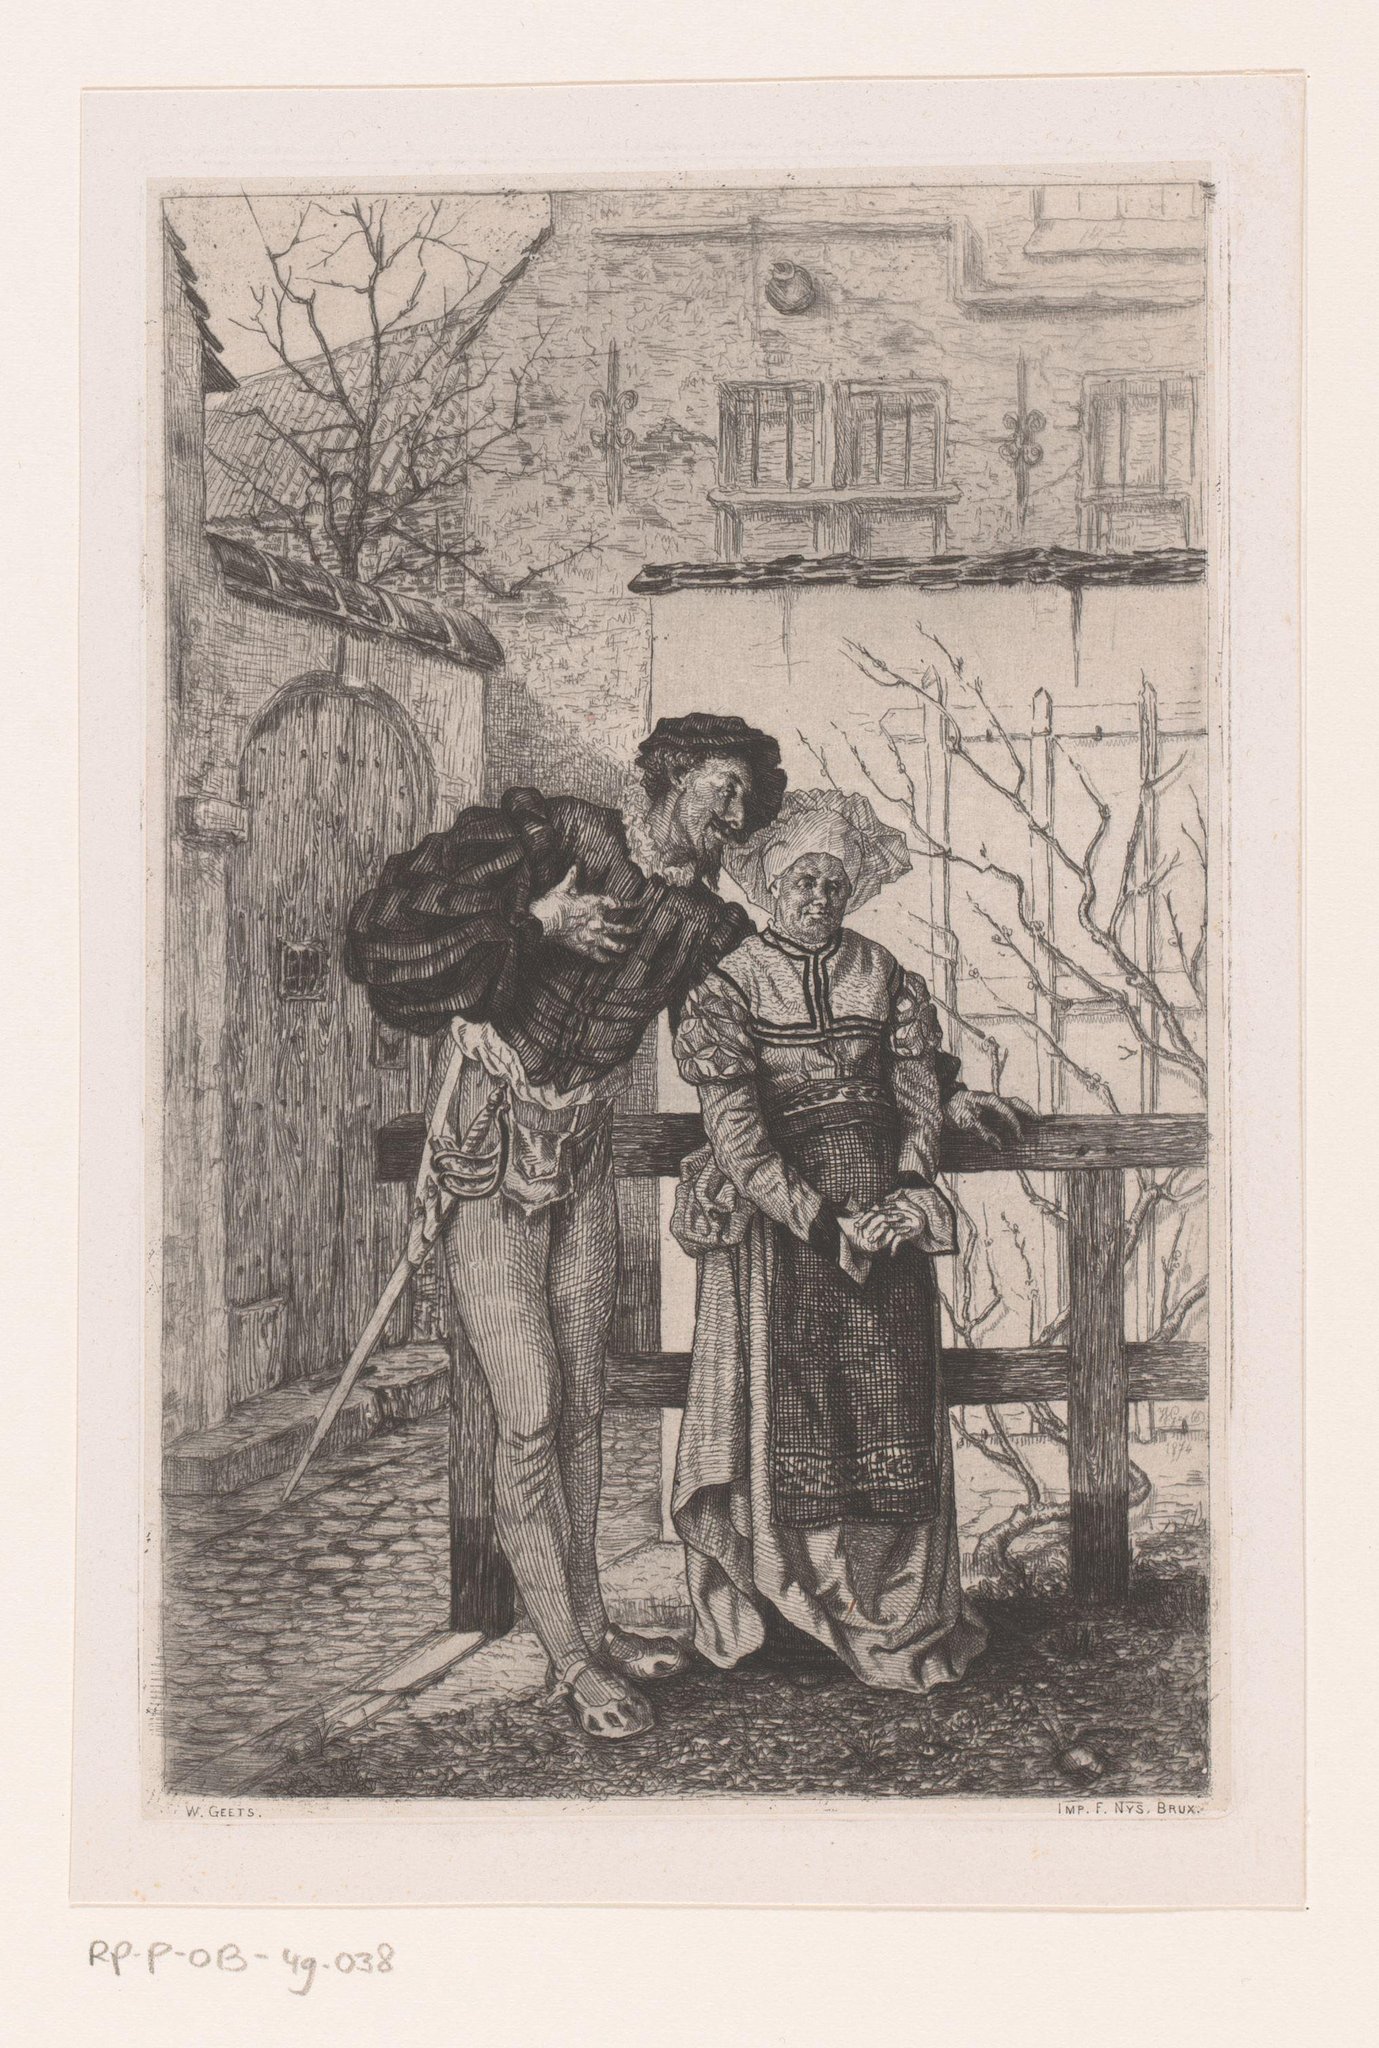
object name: print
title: Méphisto en Martha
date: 1874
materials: paper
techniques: etching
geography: brussels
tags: mephistopheles, name of the demonic tempter in the literary versions of the faust legends, (scenes from) specific works of literature: goethe, faust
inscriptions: collector's mark: Lugt 2228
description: Scène uit Faust van Goethe. Prent verschenen in: Album du journal des Beaux-Arts, dix eaux-fortes inédites. Brussel: Decq et al., 1874.